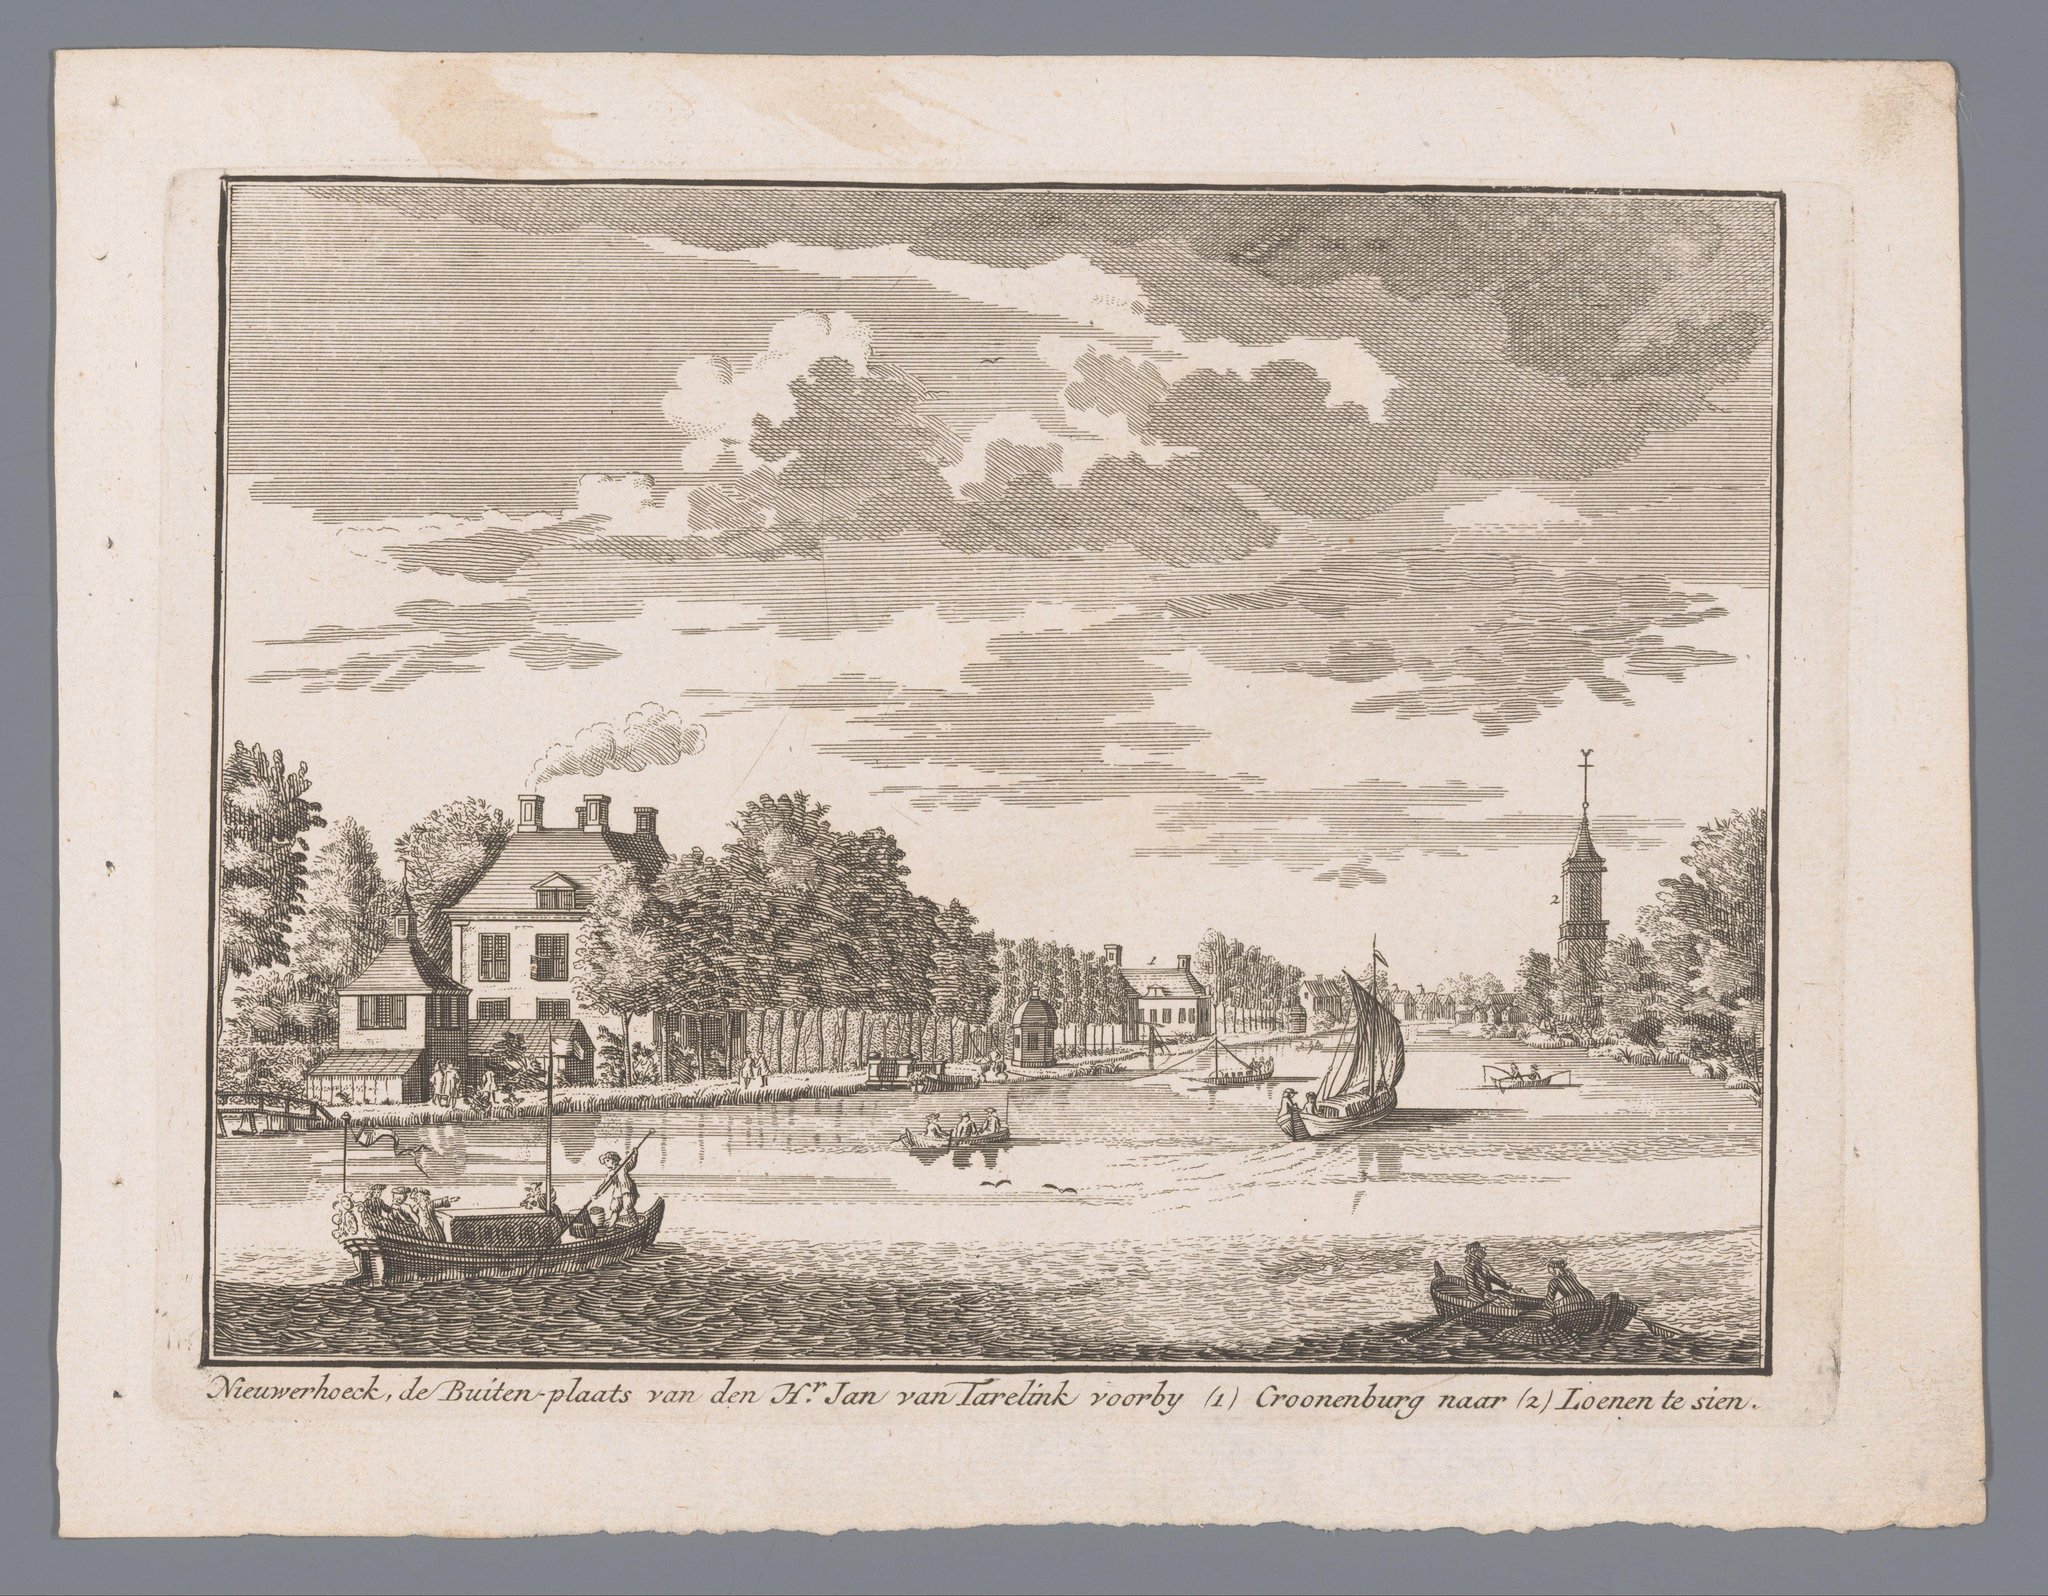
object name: print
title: Nieuwerhoeck, de Buiten-plaats van den Hr. Jan van Tarelink voorby (1) Croonenburg naar (2) Loenen te sien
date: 1718-1757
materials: paper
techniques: etching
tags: river, rural housing, e.g. country-house, villa, cottage, vecht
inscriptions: collector's mark: Lugt 2228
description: Behoort tot een reeks van elf afbeeldingen met buitenplaatsen. Kopie naar prent in: Stopendaal, Daniel. De zegepraalende Vecht, vertoonende verscheidenen gesichten van lustplaatsen, heeren huysen en dorpen, beginnende van Uitrecht en met Muyden besluytende. Amsterdam: Weduwe Nicolaas Visscher, 1719.